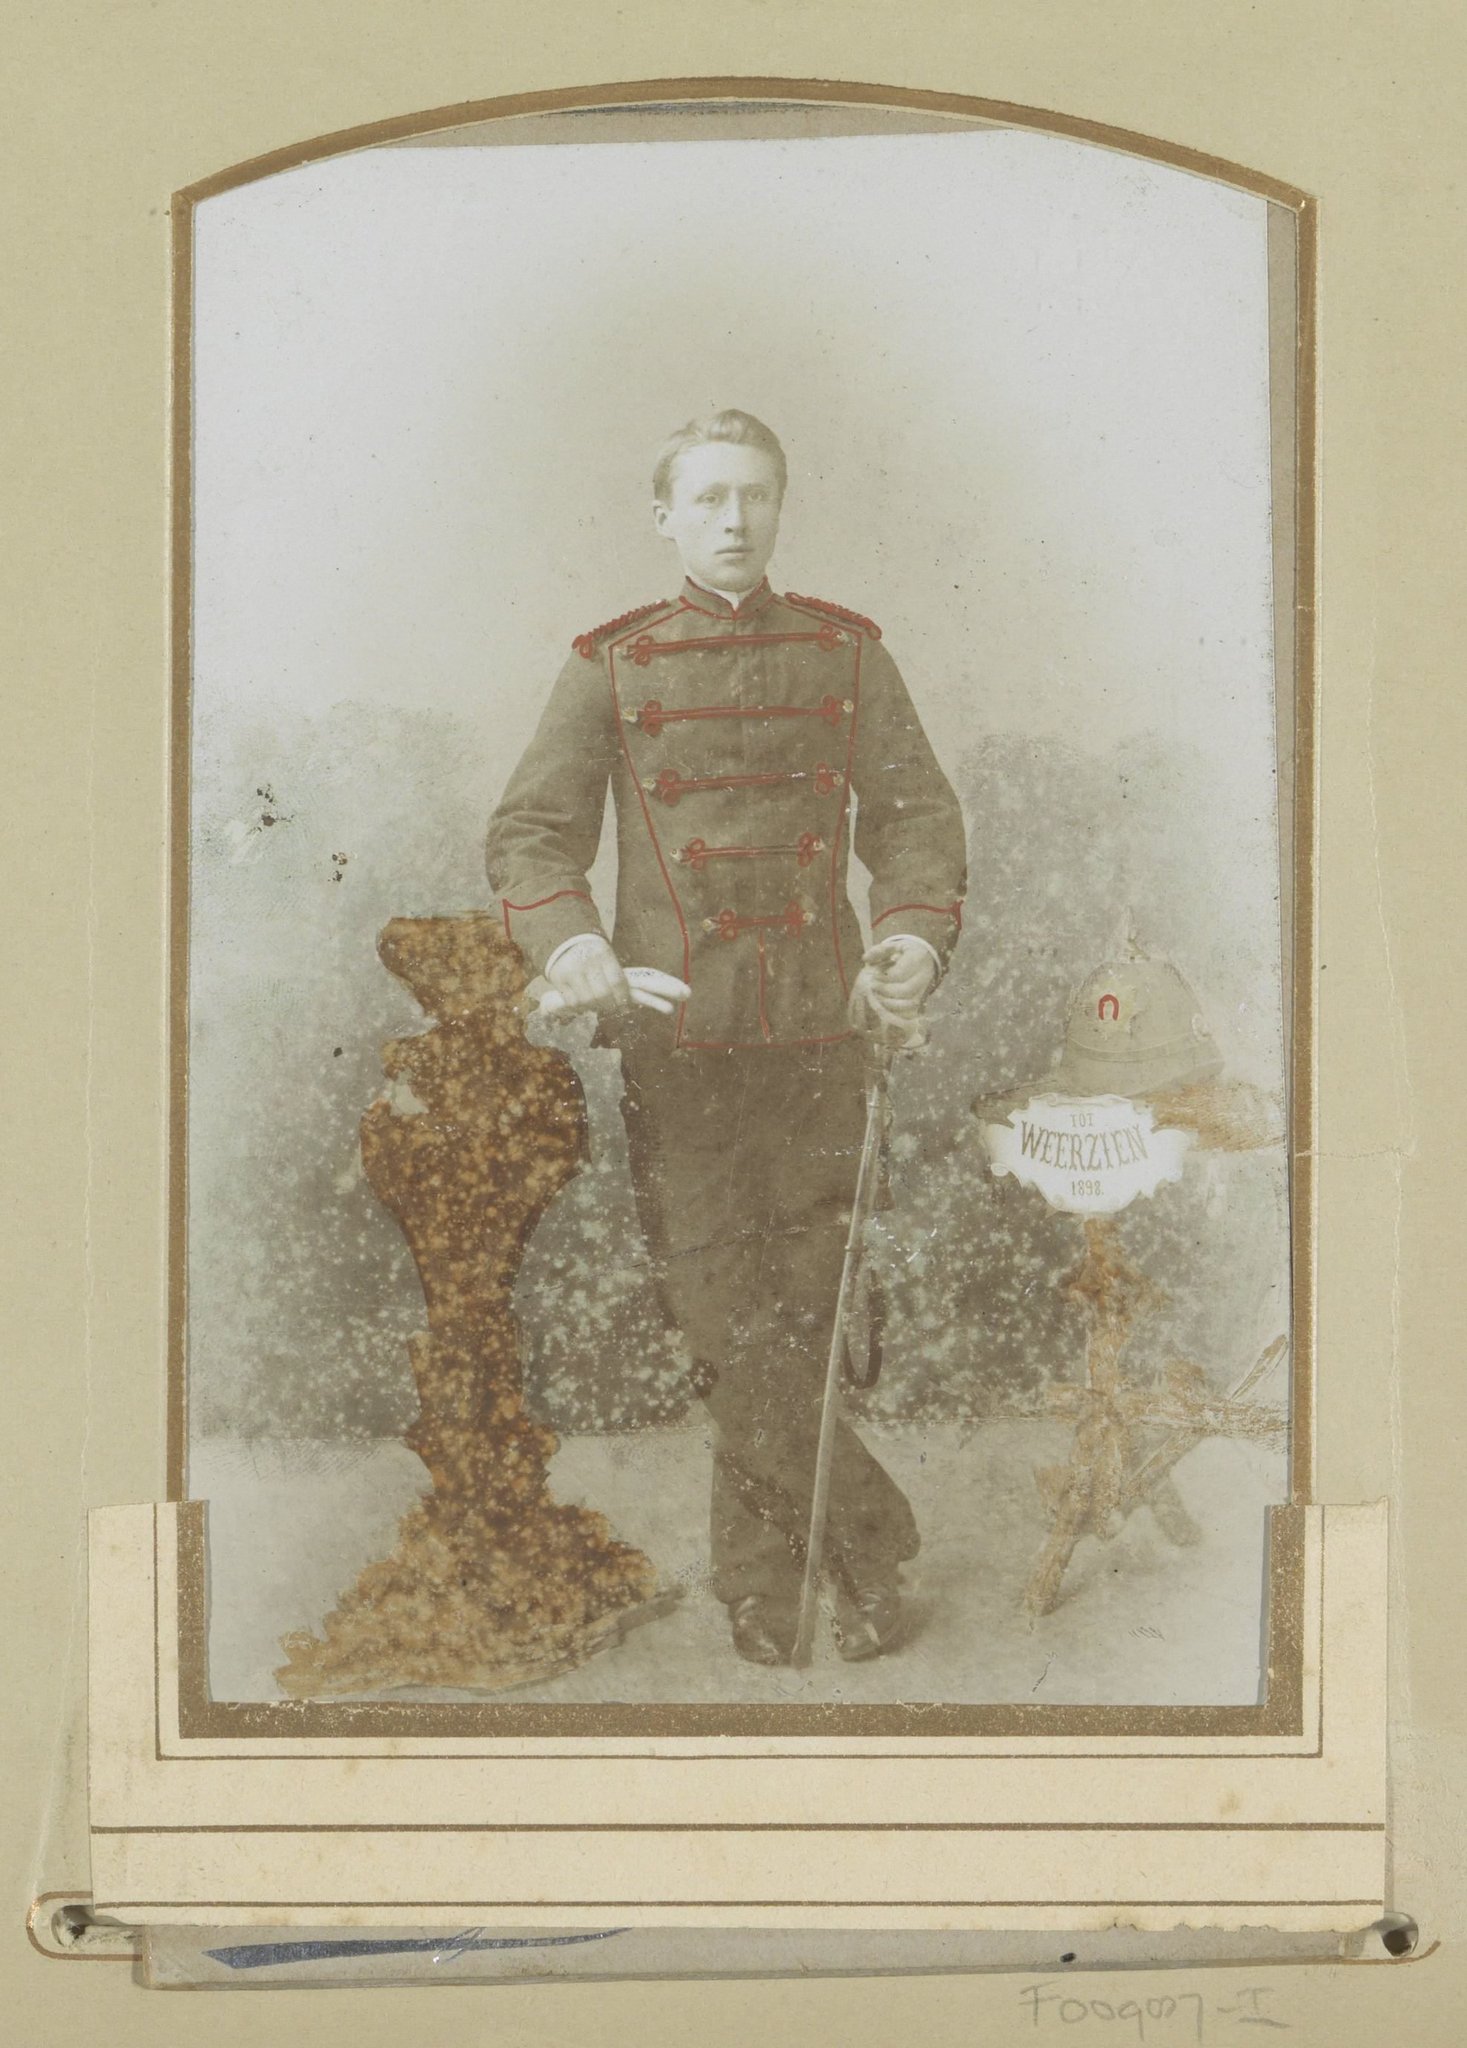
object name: photograph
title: Portret van een (vermoedelijk) Nederlandse militair, staand naast een helm en een bord met opschrift 'tot weerzien 1898'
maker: robert ziegler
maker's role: fotograaf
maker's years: 1863-1931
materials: cardboard, paper, photographic support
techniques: collodion silver print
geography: harderwijk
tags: helmet, studio requisites ~ photographer, warfare; military affairs, (military) uniforms, division of armed forces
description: Onderdeel van Album met cartes-de-visite en kabinetfoto's van militairen in uniform.